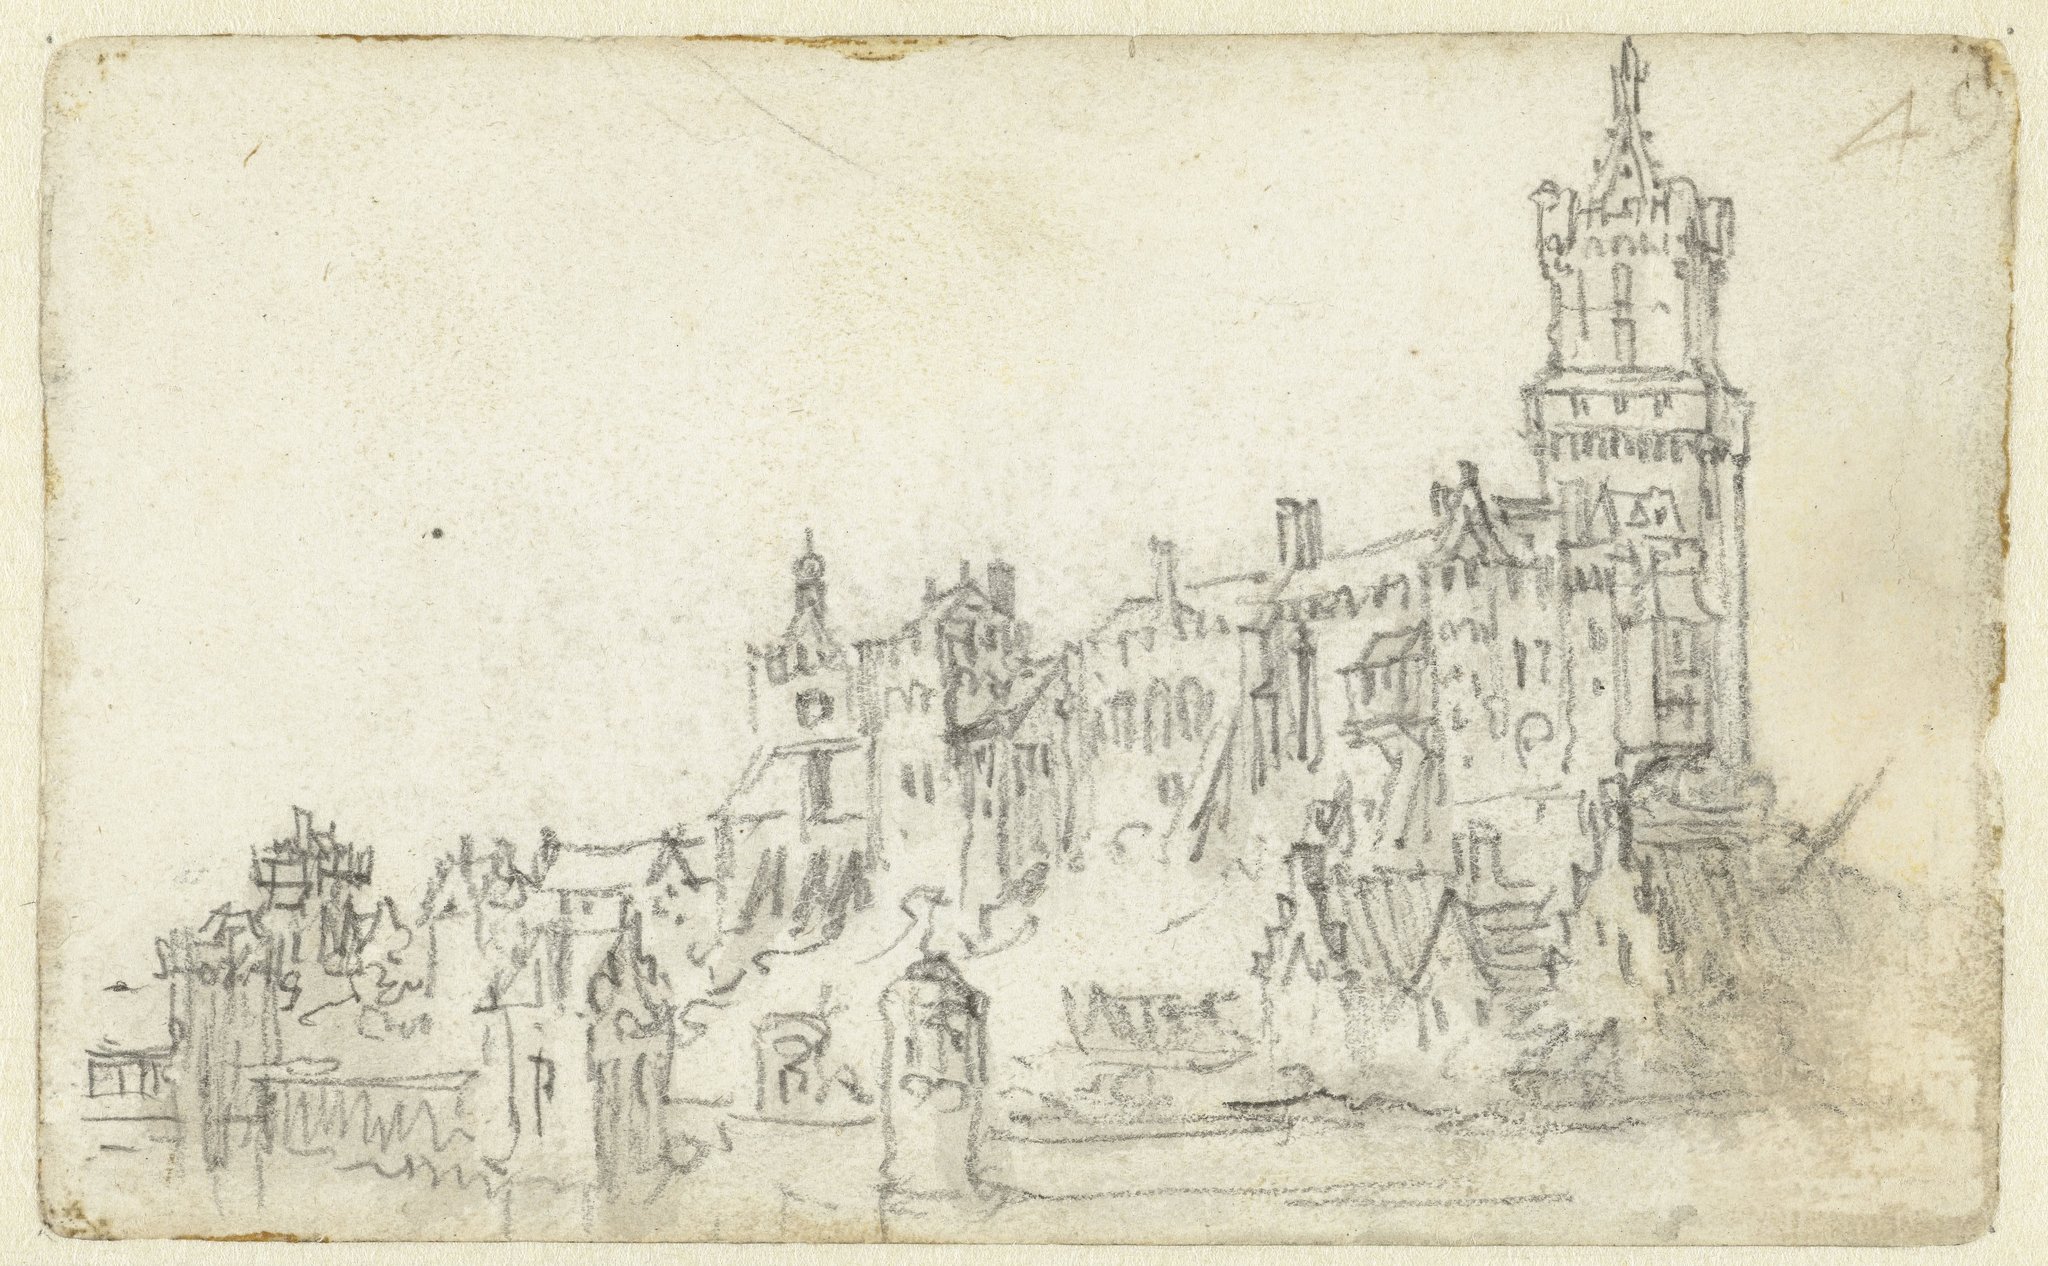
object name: drawing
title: Bladen afkomstig uit Schetsboek van 165-1651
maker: jan van goyen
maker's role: draughtsman, painter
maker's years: 1596-1656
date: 1650-1651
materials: chalk, paper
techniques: brush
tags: public road, cleves